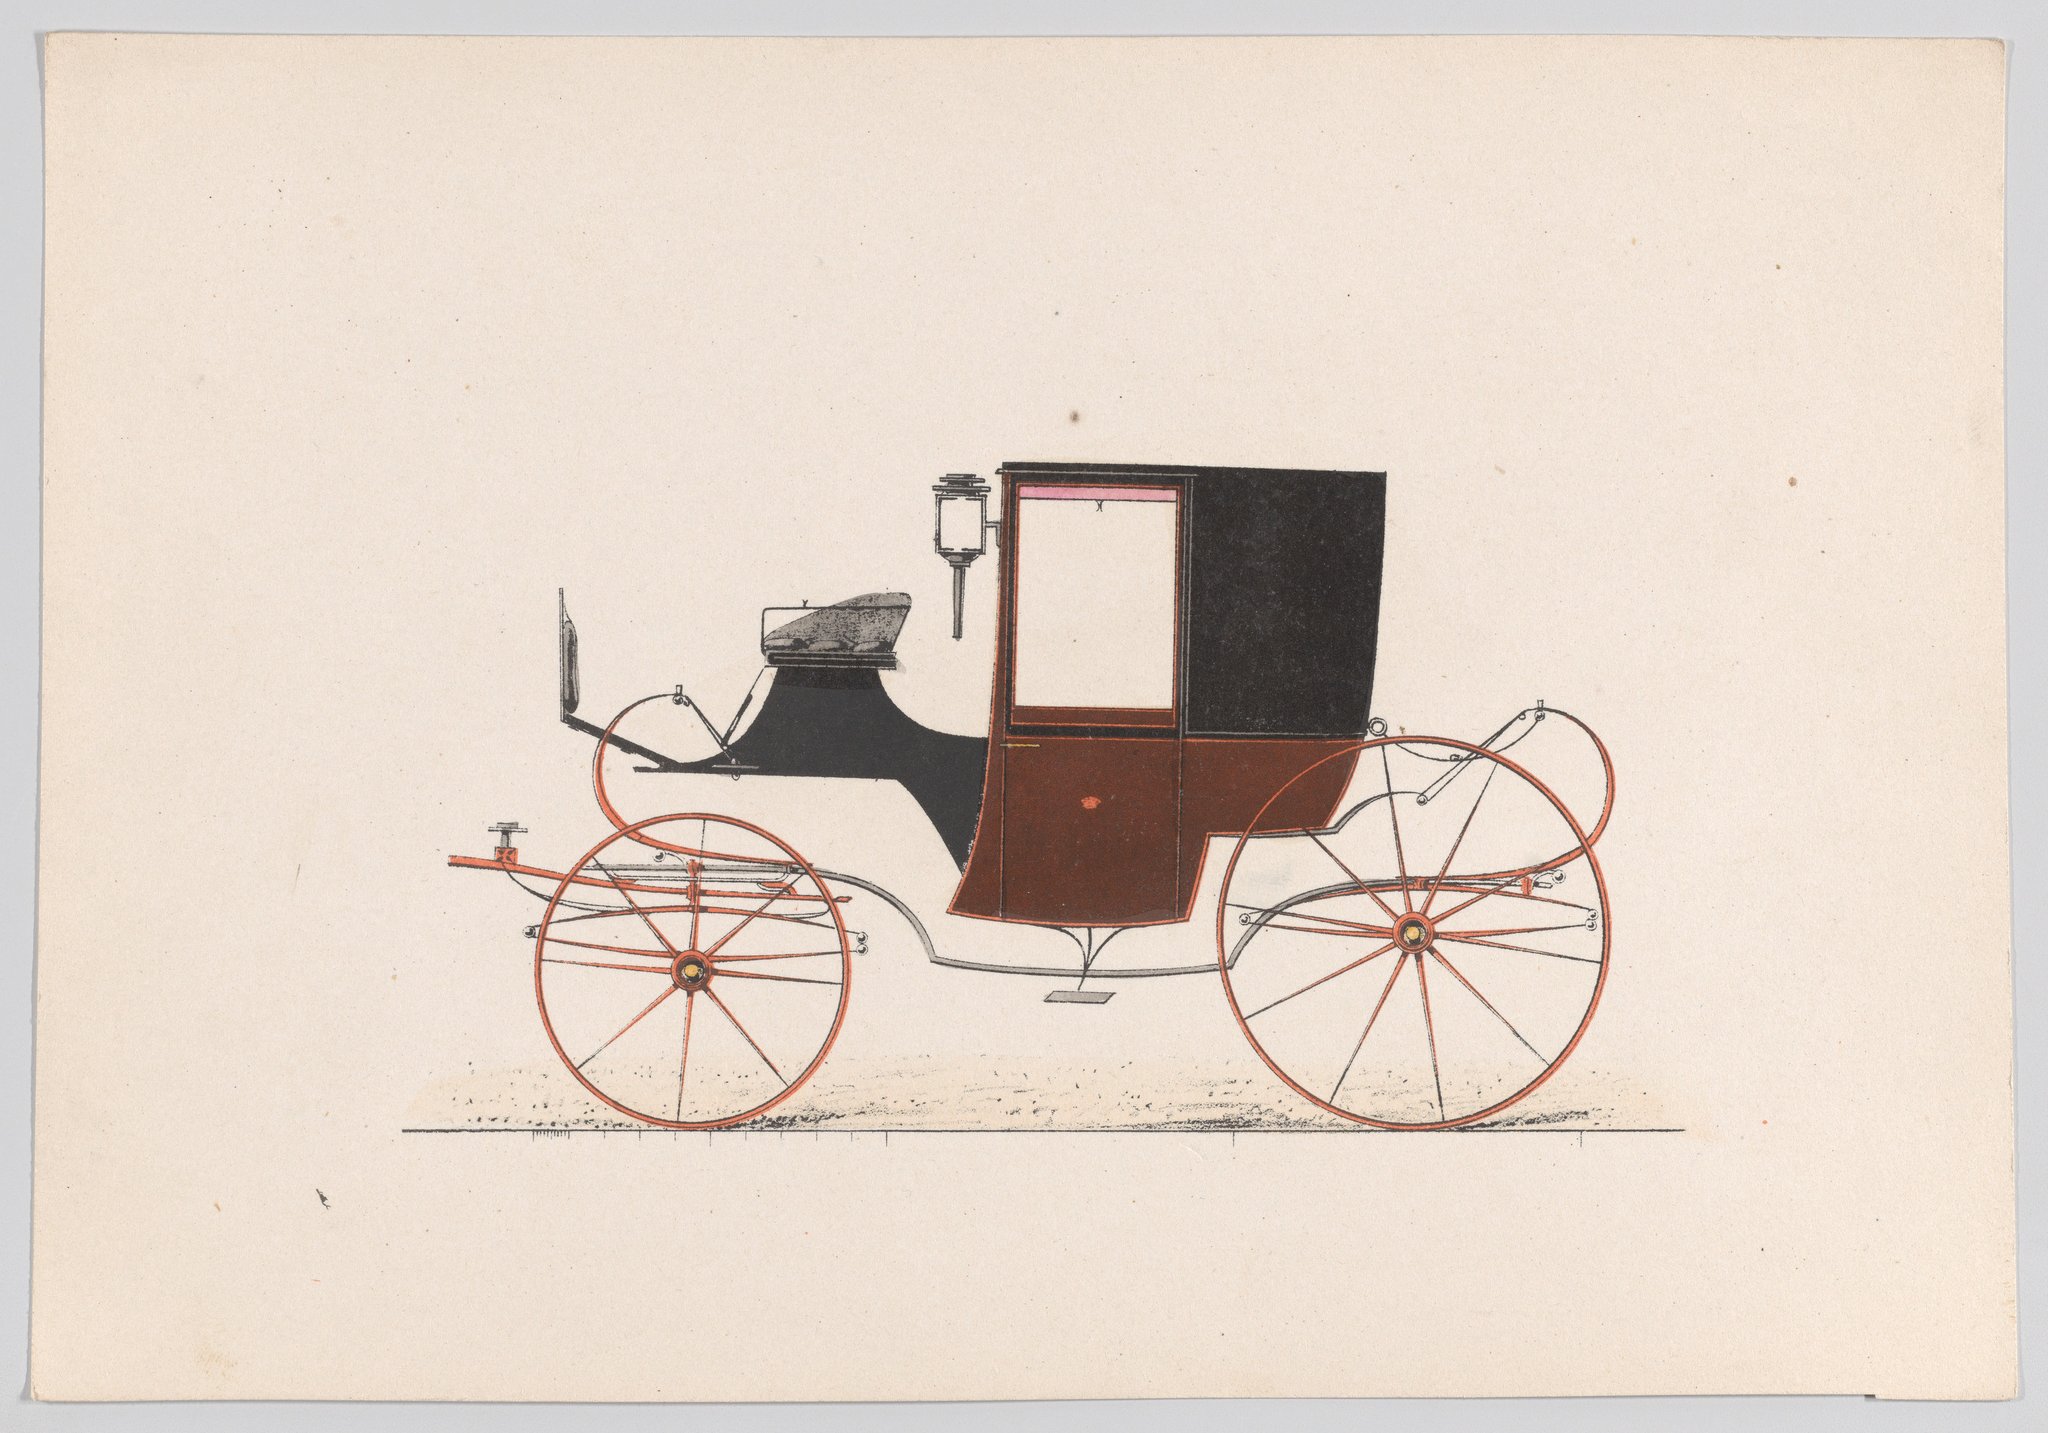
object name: print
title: Design for Brougham/D'Orsay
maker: anonymous, french, 19th century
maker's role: artist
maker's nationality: french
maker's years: 1800-1900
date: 1870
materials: gum arabic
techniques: hand coloring, lithograph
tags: carriages